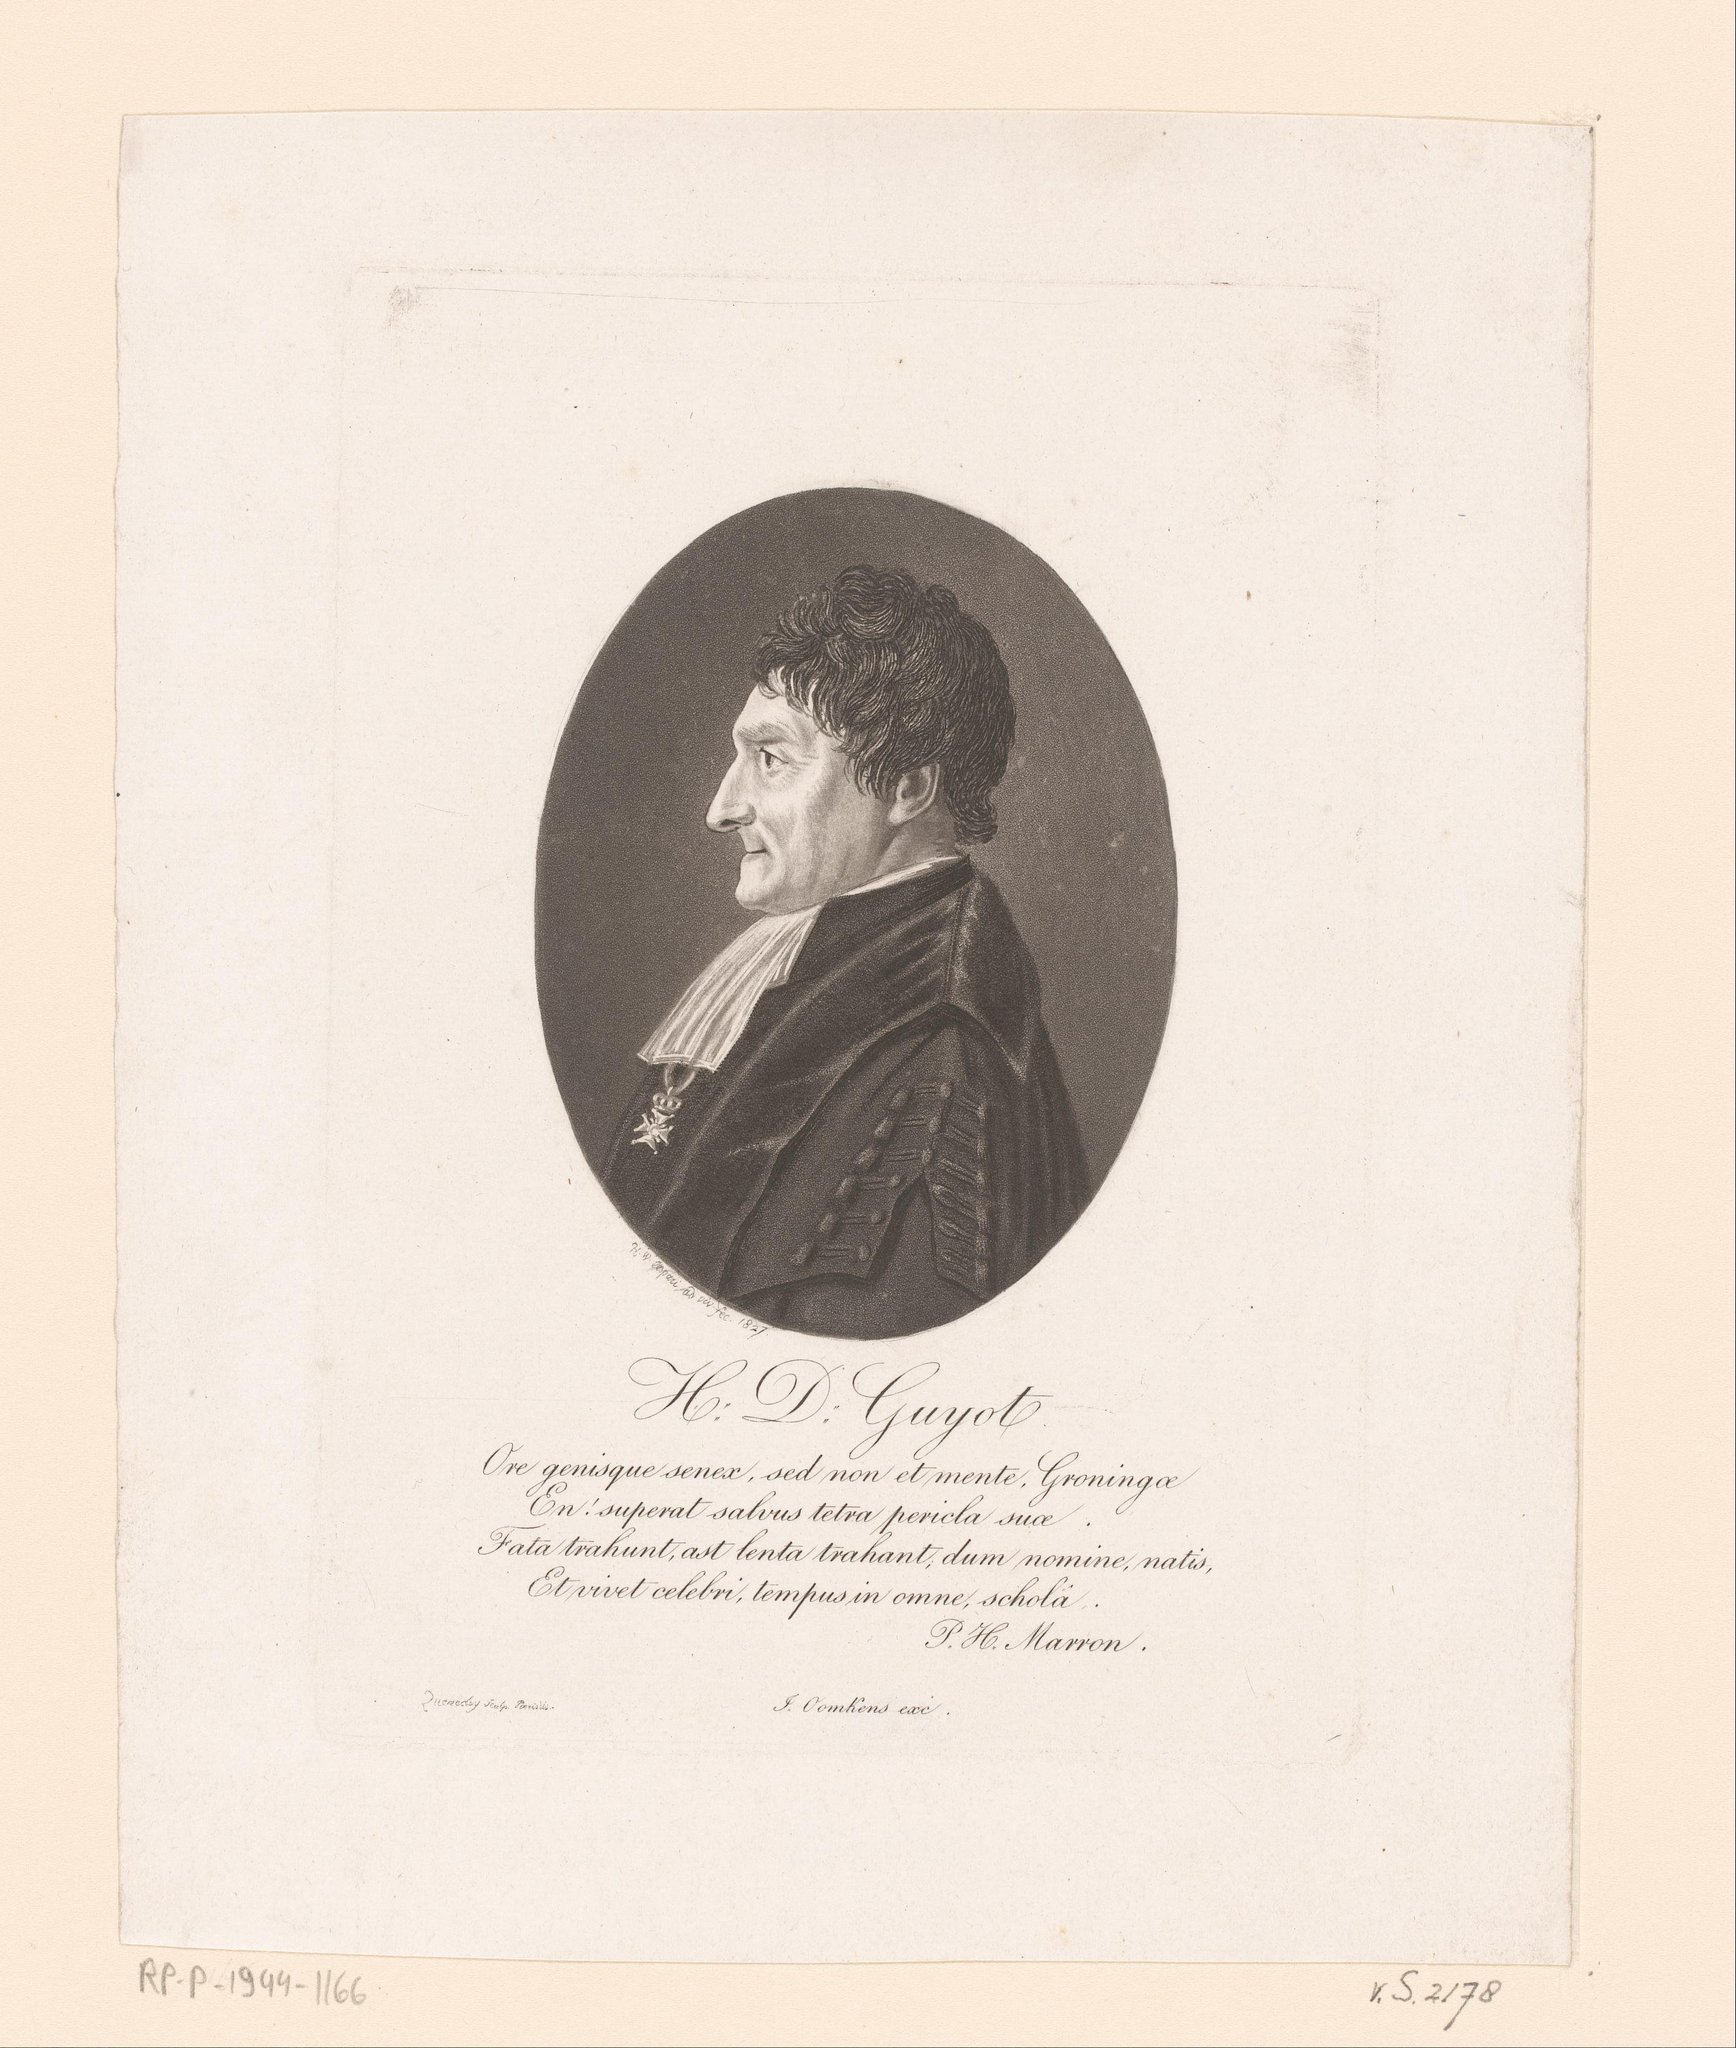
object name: print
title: Portret van Henri Daniël Guyot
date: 1766-1830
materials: paper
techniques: aquatint, etching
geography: france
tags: france, historical persons, organization, functionaries and dignitaries in churches and in related institutions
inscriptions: collector's mark: Lugt 2228